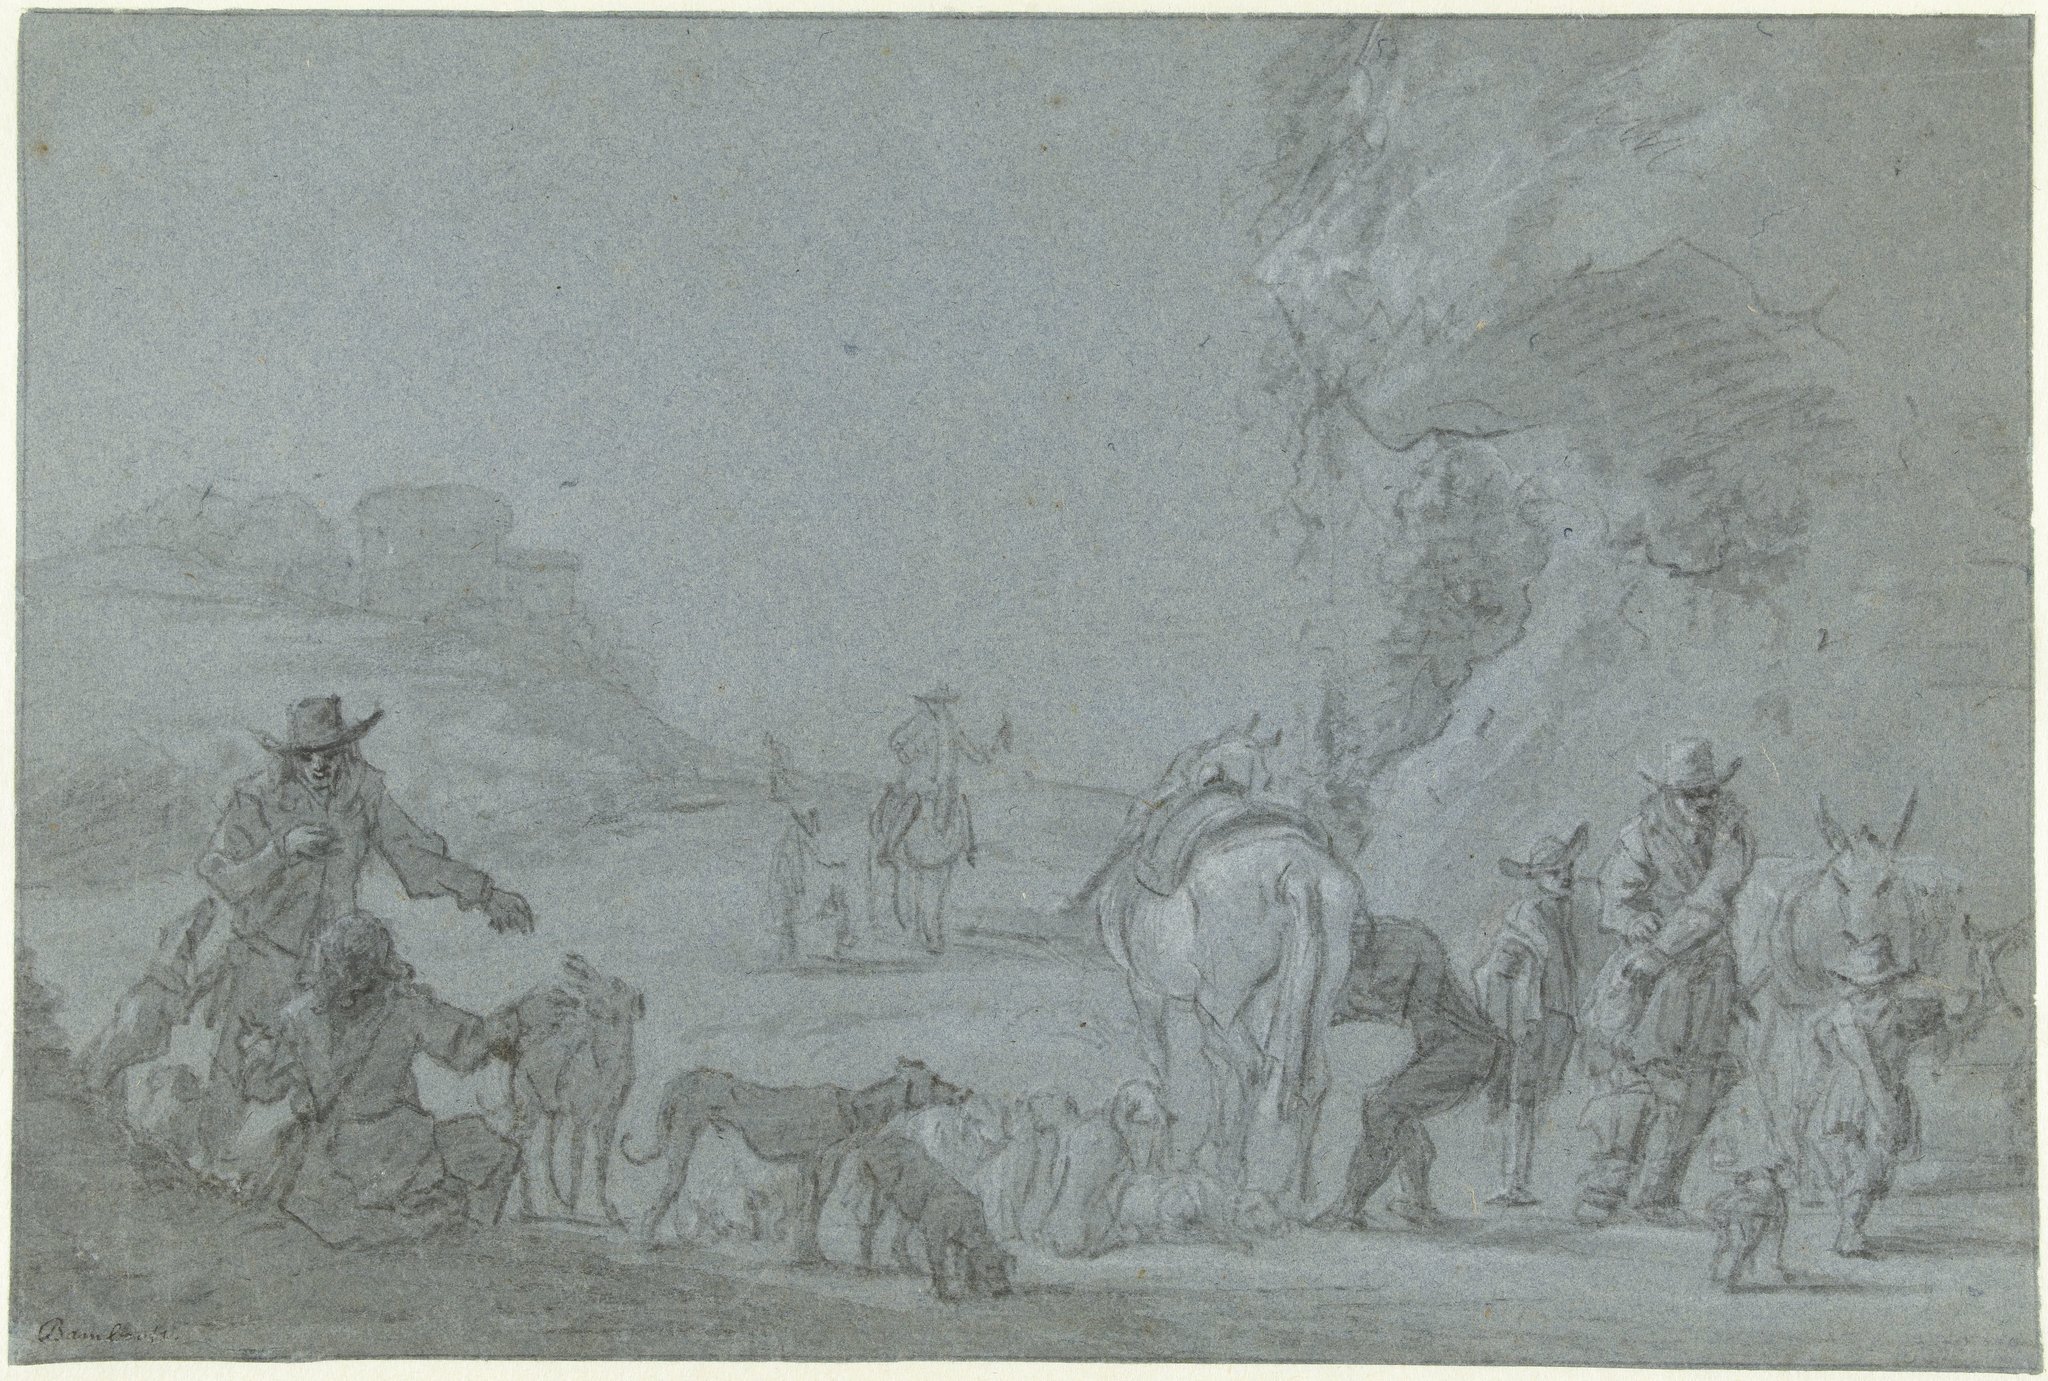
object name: drawing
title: Resting Huntsmen in an Italianate Landscape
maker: jan asselijn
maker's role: draughtsman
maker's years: 1610-1652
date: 1636-1646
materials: chalk, ink, paper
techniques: brush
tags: hunters resting during the hunt